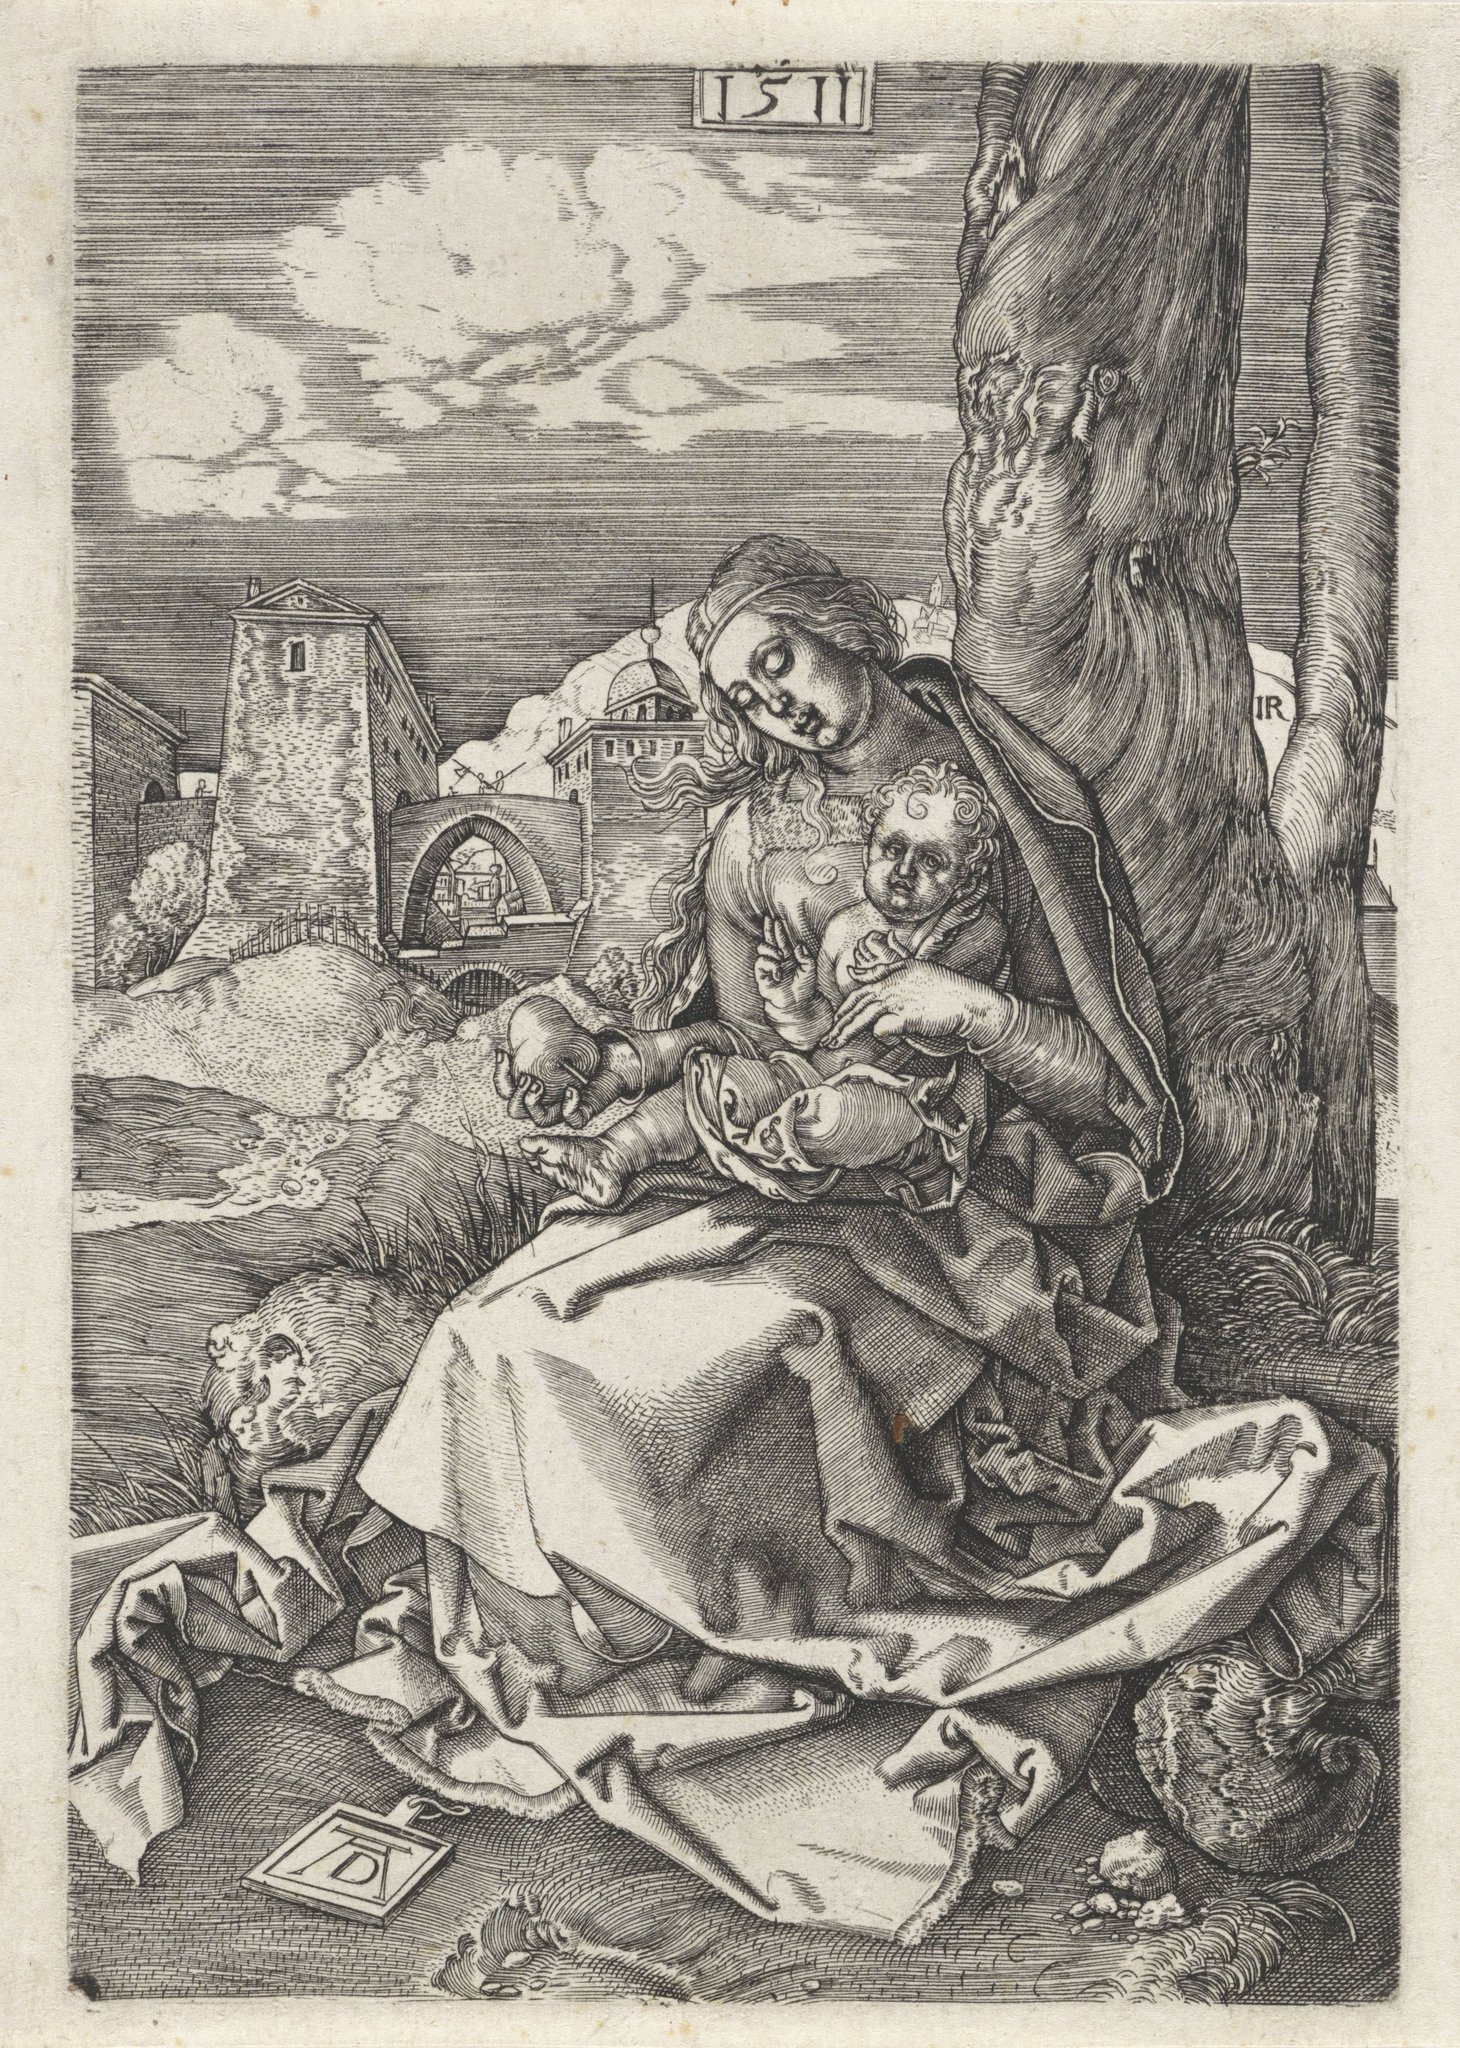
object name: print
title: Maria met kind en een peer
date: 1511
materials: paper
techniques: engraving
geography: antwerp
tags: fruits: pear, mary sitting or enthroned, the christ-child in front of her, sitting in her lap (or in front of her bosom)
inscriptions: collector's mark: Lugt 923, collector's mark: Lugt 2228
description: Maria zit bij een boom met het Christuskind op schoot en een peer in de hand. Aan haar voeten ligt een bordje met het monogram van Albrecht Dürer. Op de achtergrond een burcht of stad.